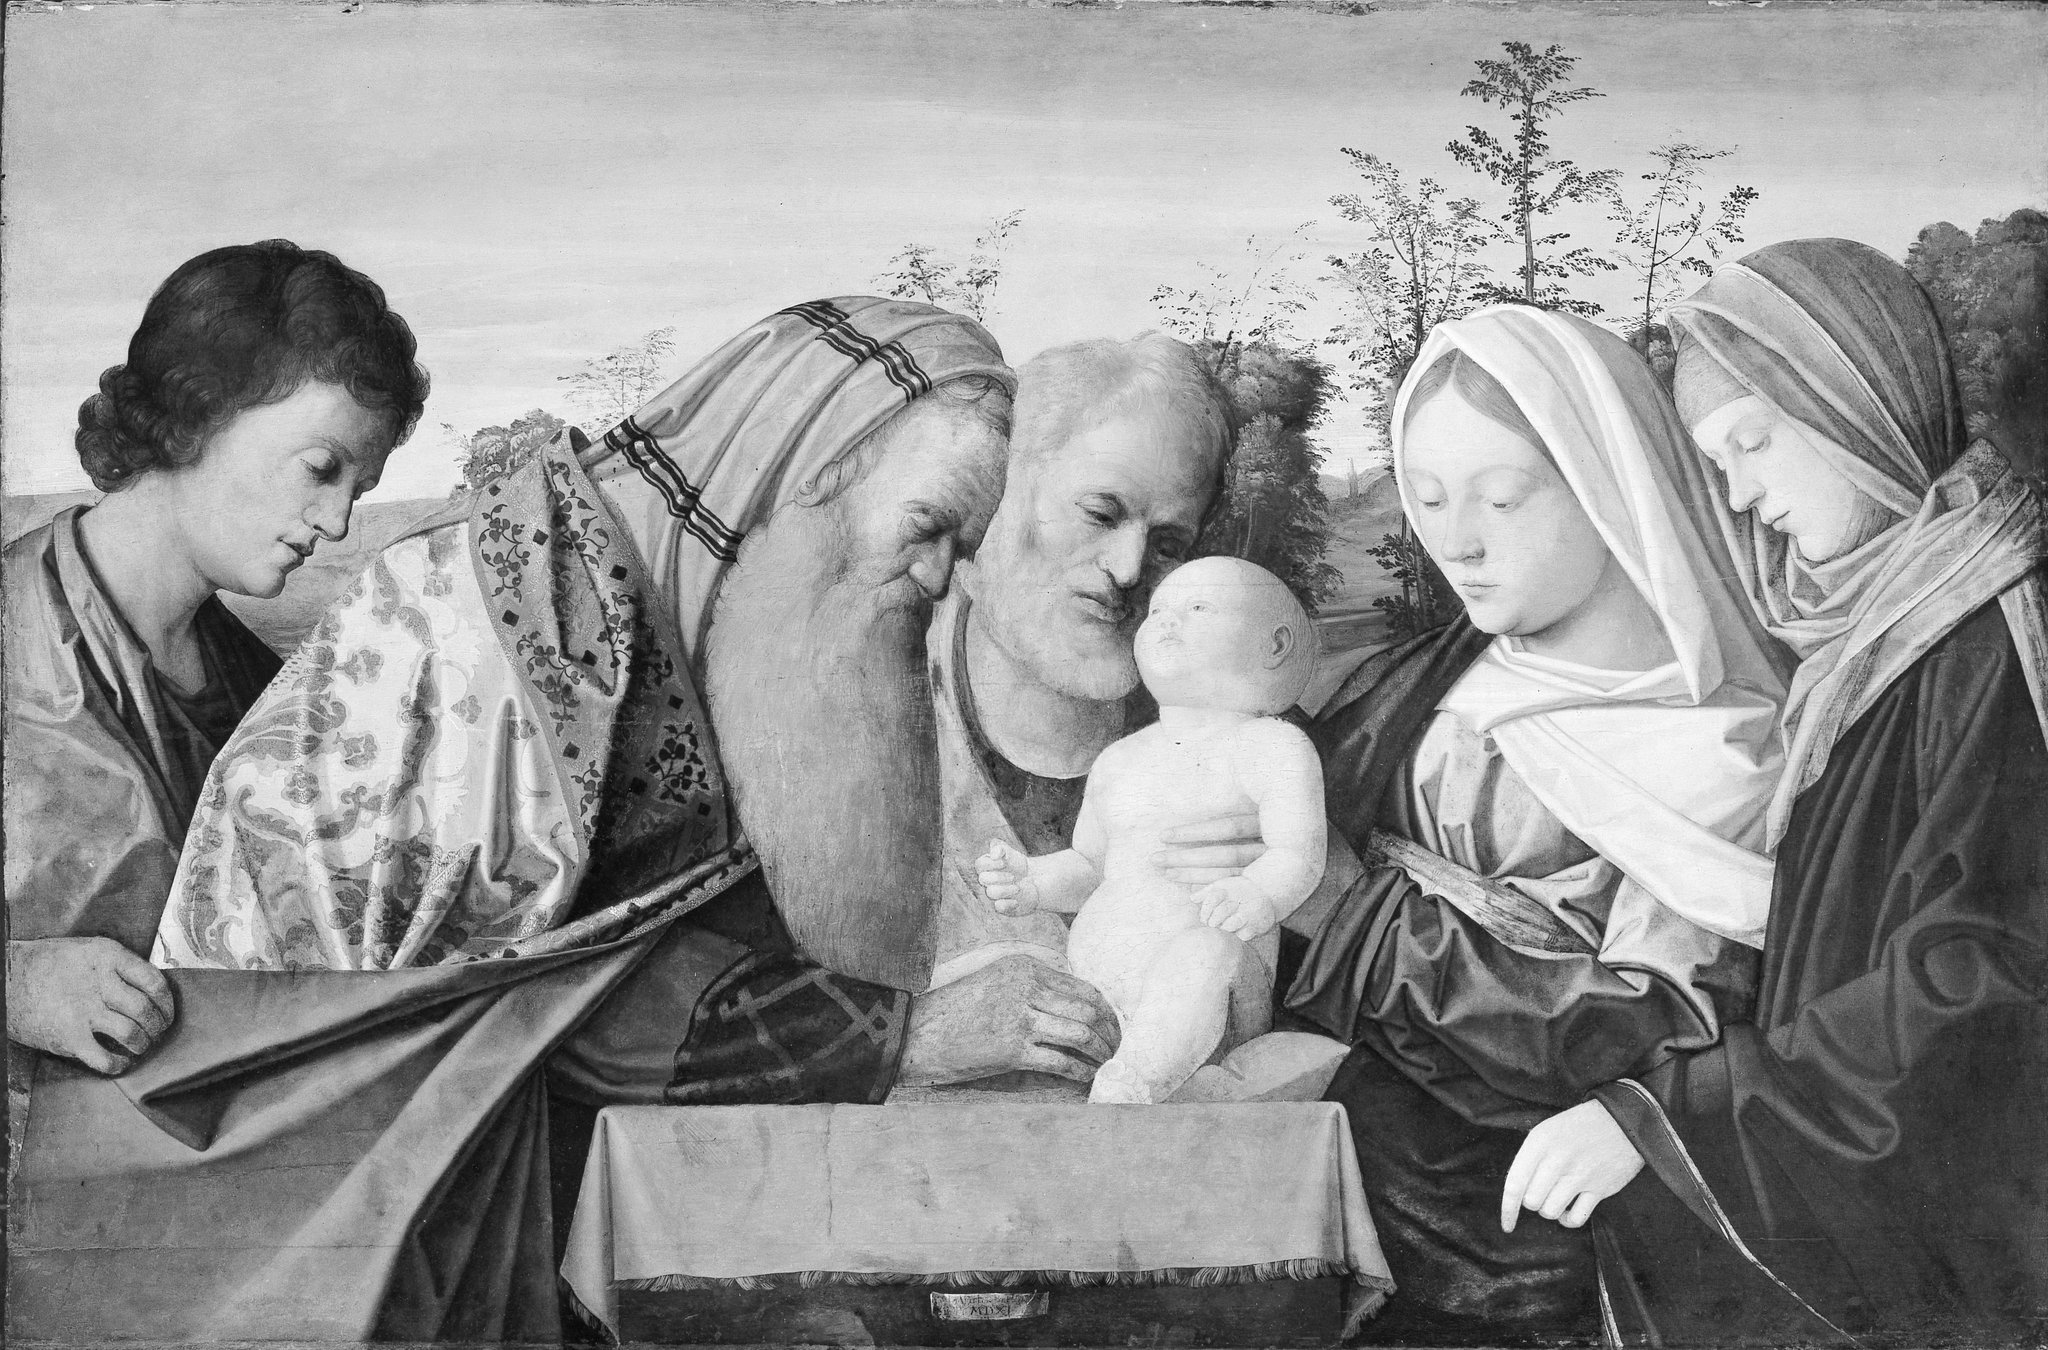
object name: painting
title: The Circumcision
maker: giovanni bellini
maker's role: artist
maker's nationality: italian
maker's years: 1424-1516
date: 1511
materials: oil, wood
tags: men,women,virgin mary,jesus,circumcision,joseph,priests